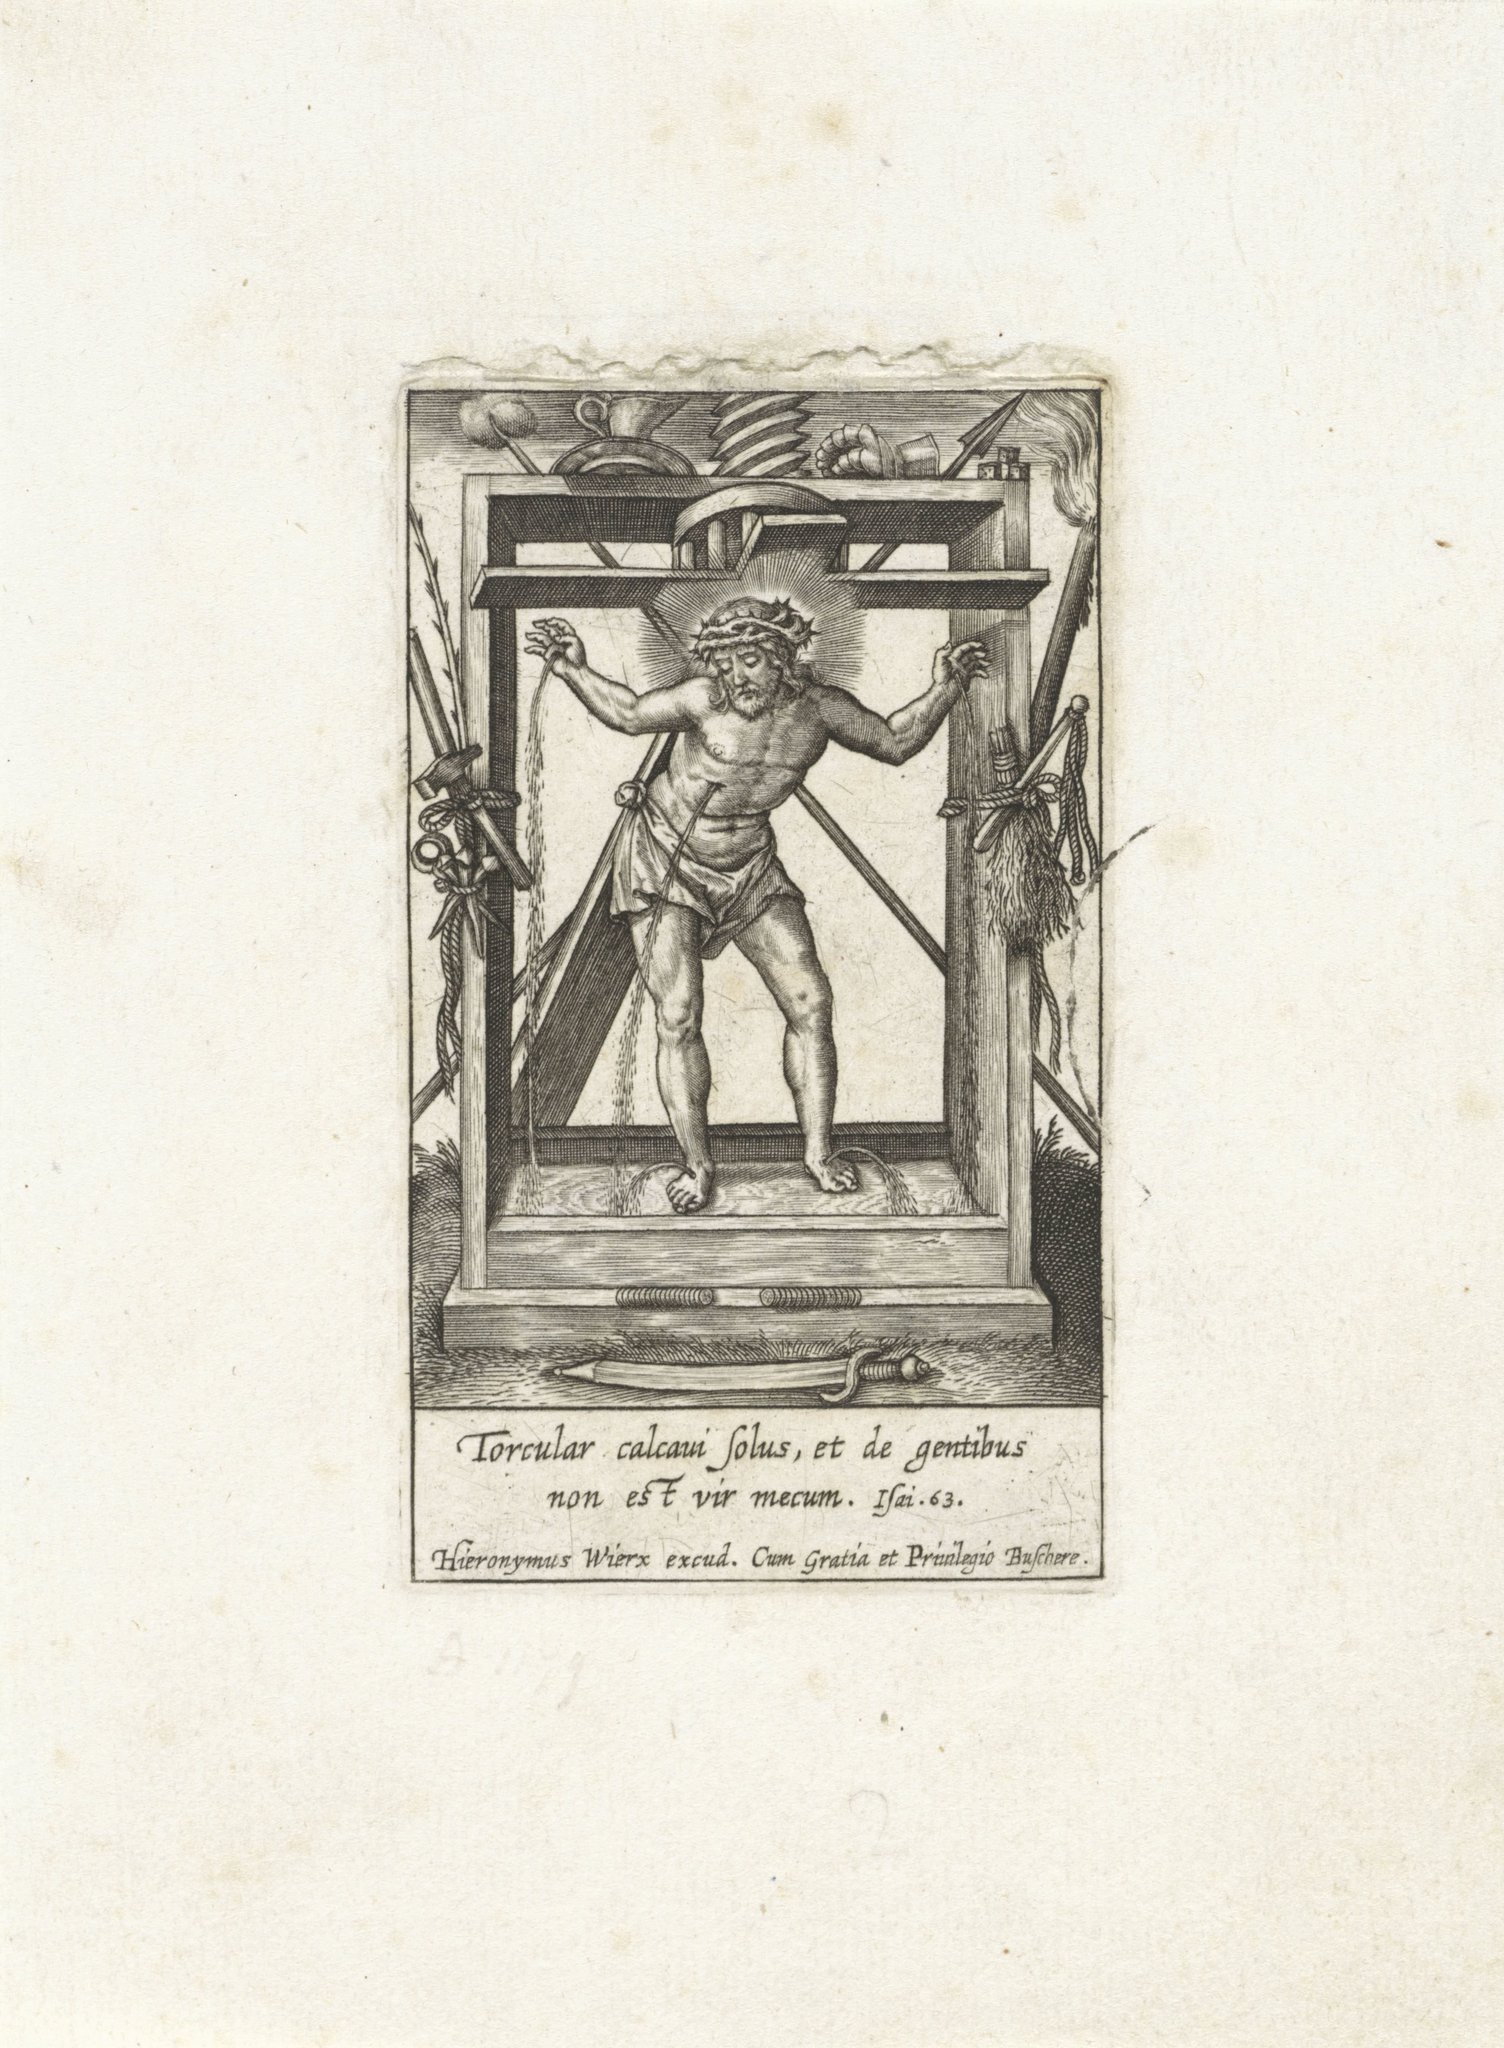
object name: print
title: Christus in de wijnpers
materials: paper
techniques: engraving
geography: antwerp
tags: christ in the wine-press, 'christus in der kelter' (is. 63:3)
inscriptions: collector's mark: Lugt 2228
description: Christus staat gebukt onder een wijnpers, met het kruis op zijn rug. Het bloed vloeit uit zijn kruiswonden. Rondom de pers verschillende passiewerktuigen. In de marge een tweeregelig Bijbelcitaat uit Jes. 63 in het Latijn.